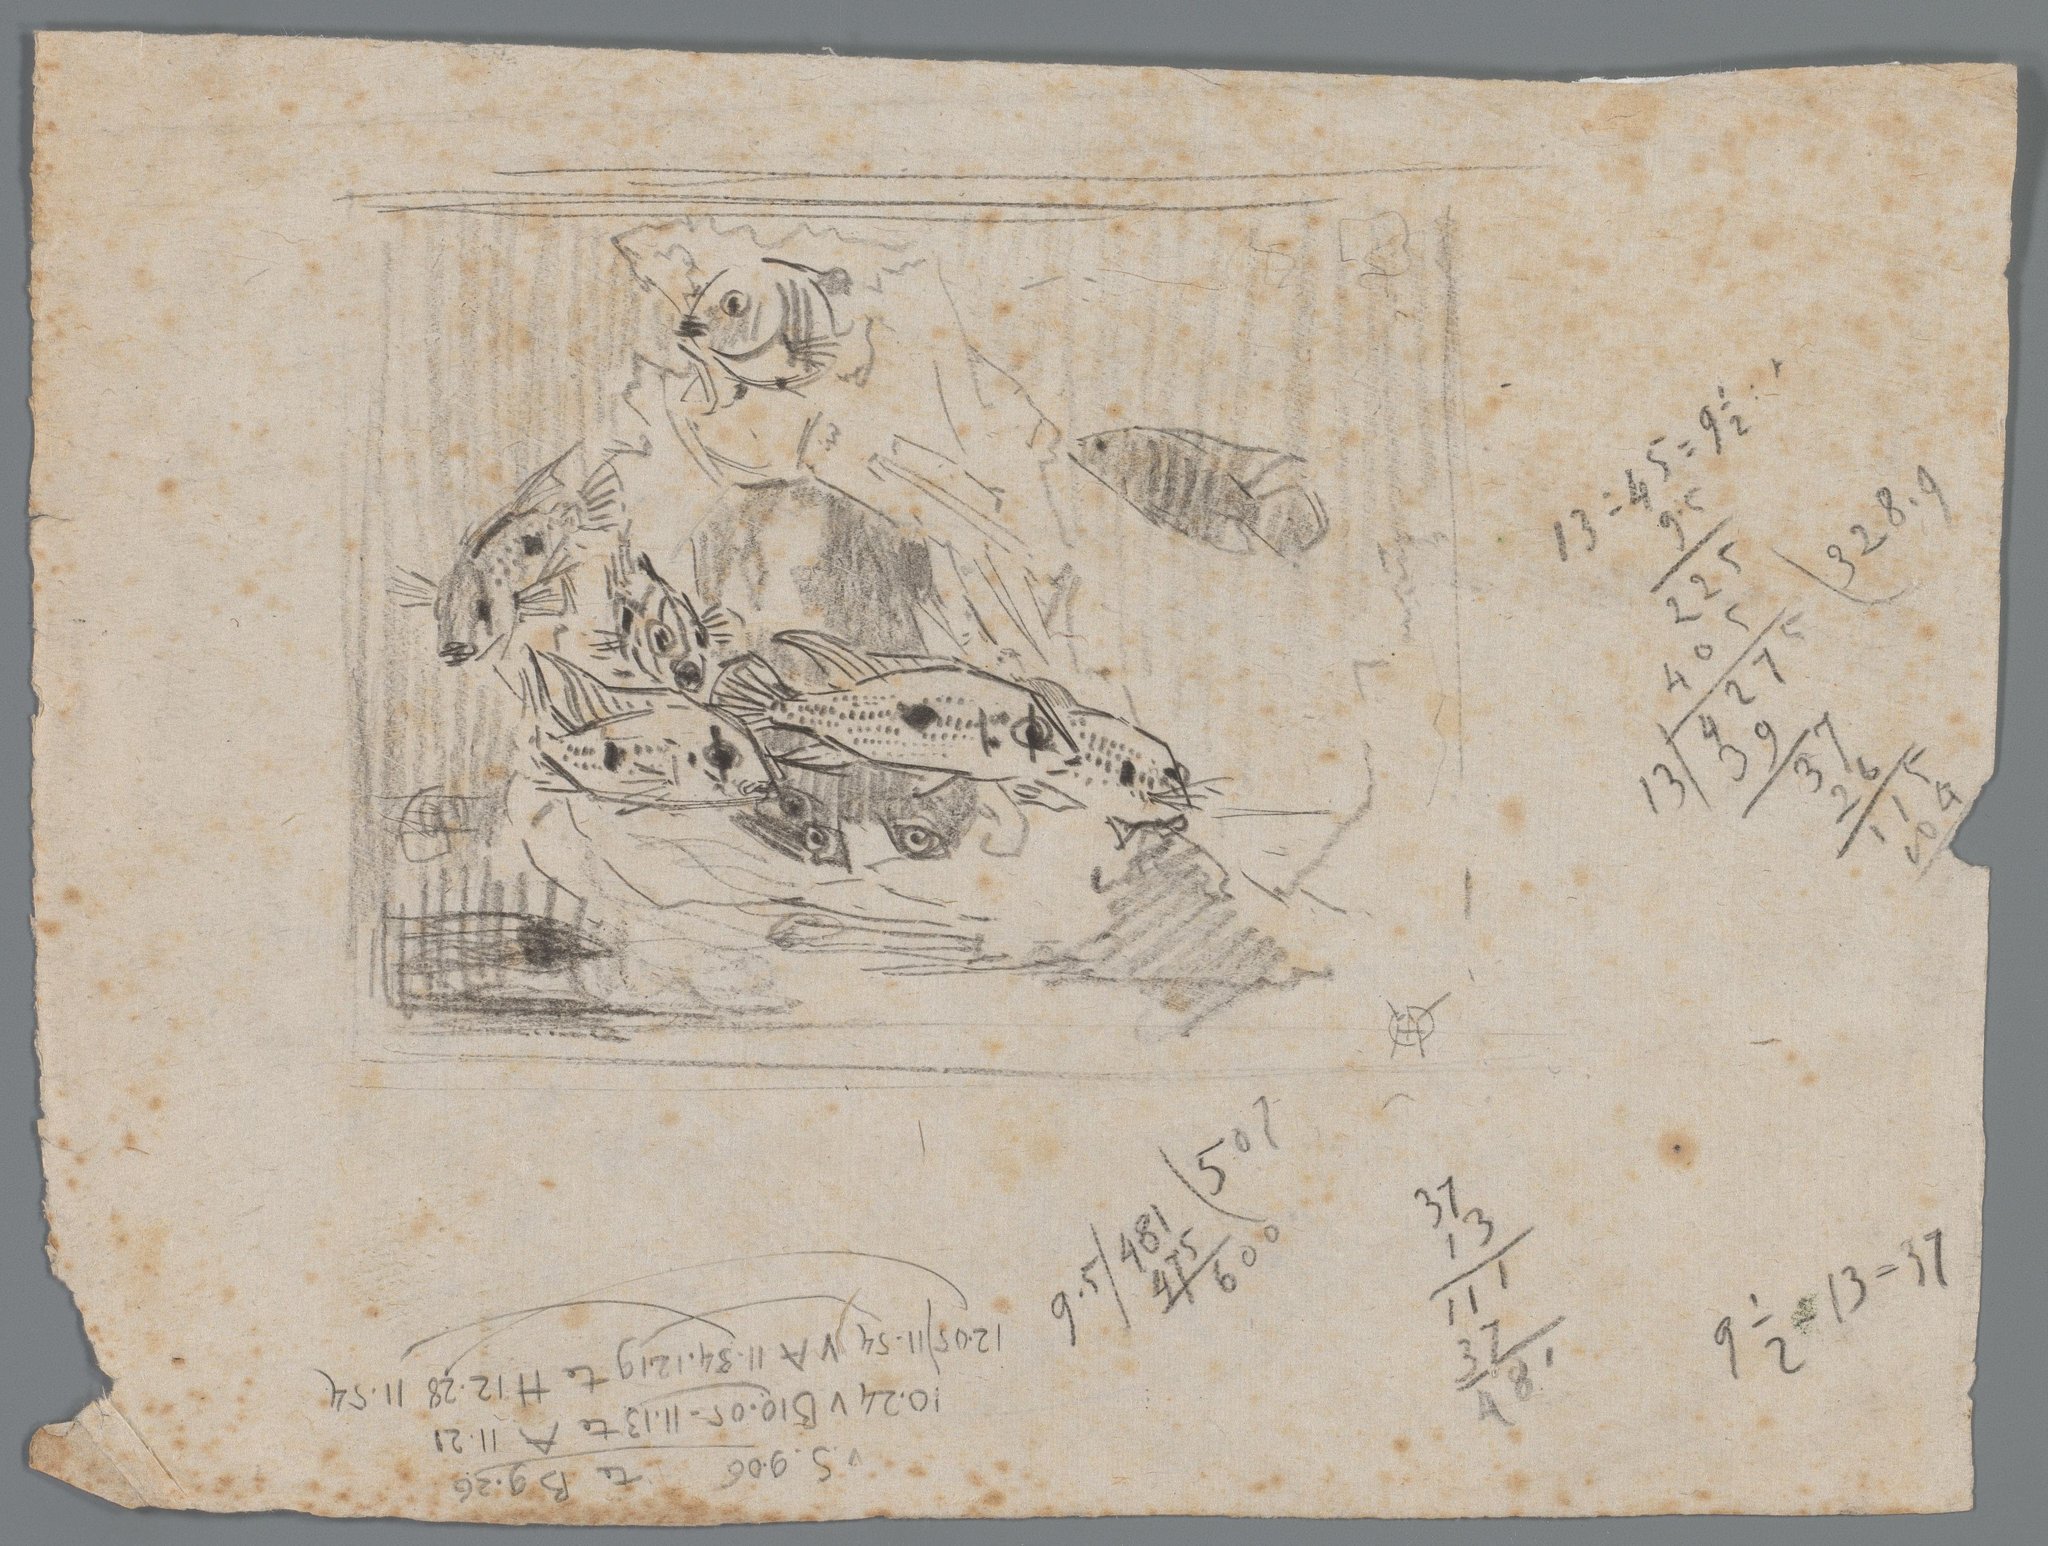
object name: drawing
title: Vissen in een aquarium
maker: gerrit willem dijsselhof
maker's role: designer, draughtsman, print maker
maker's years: 1866-1924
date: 1876-1924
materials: chalk, paper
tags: aquarium, fishes